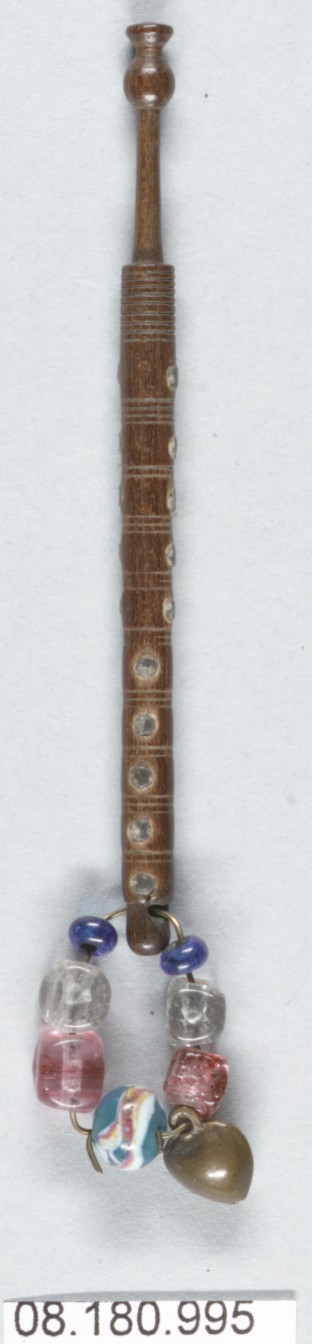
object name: bobbin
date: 1801-1900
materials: metal, wood